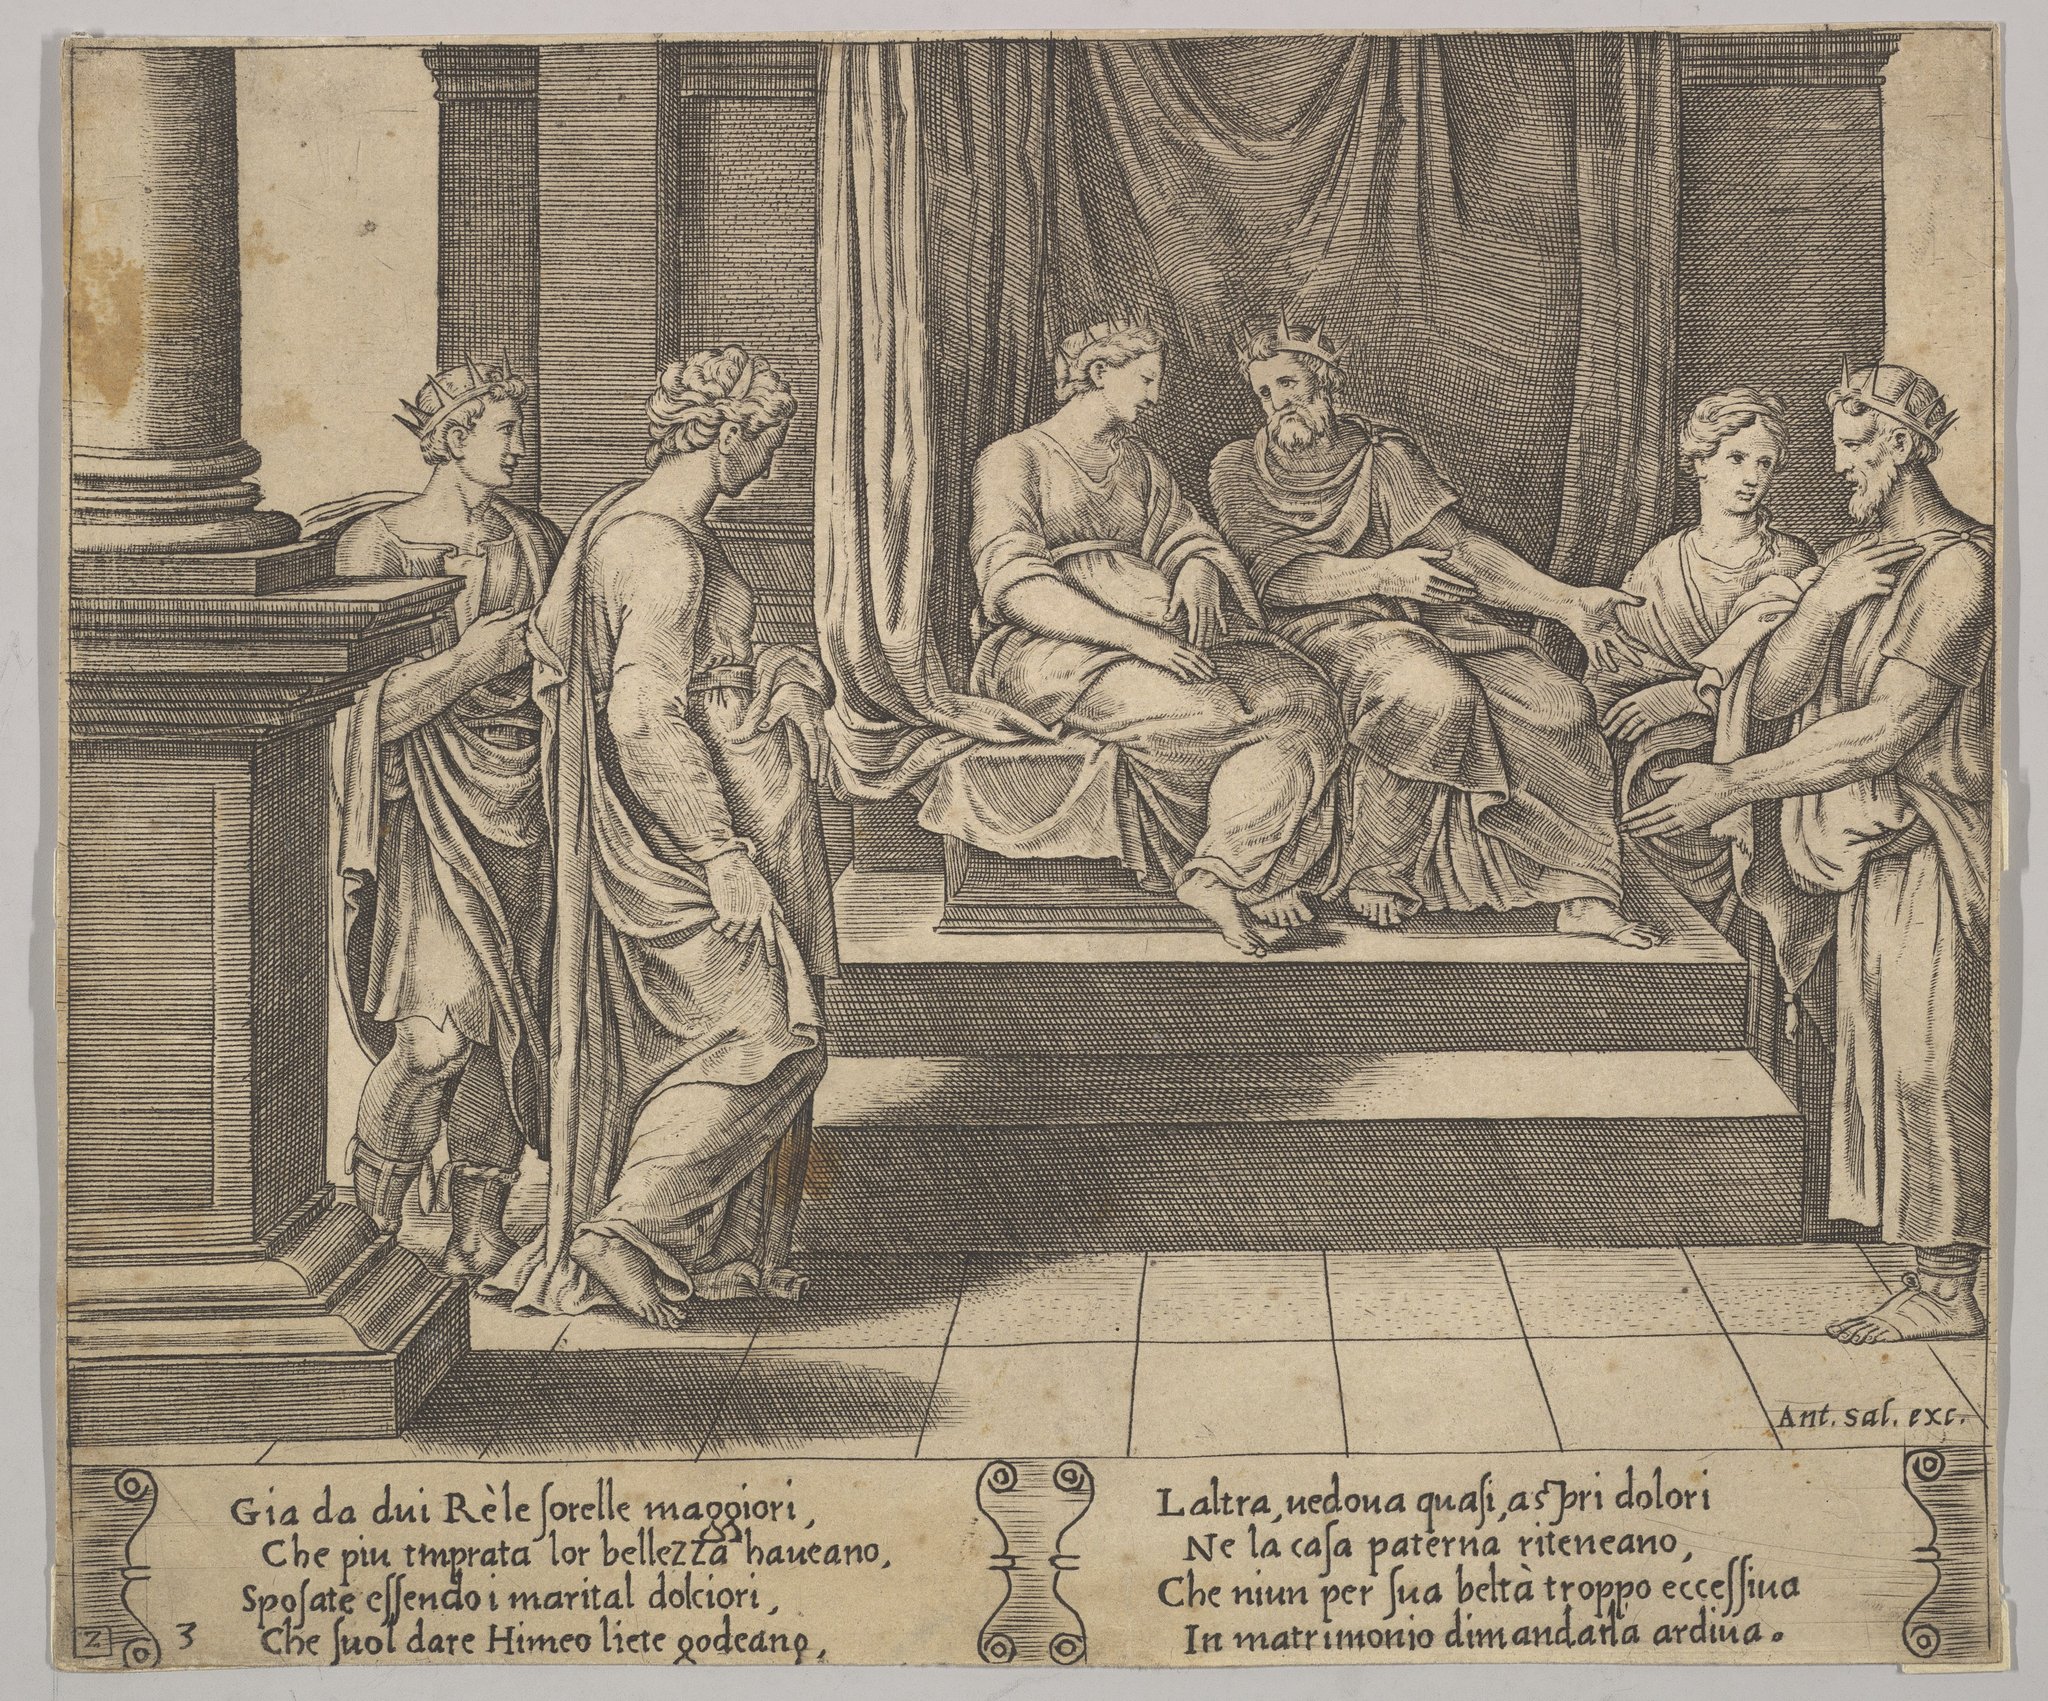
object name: print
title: Plate 3: Psyche's two sisters are married to kings, from "The Fable of Psyche"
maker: master of the die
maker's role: artist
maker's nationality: italian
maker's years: 1525-1560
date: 1530-1560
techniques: engraving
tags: kings,men,psyche